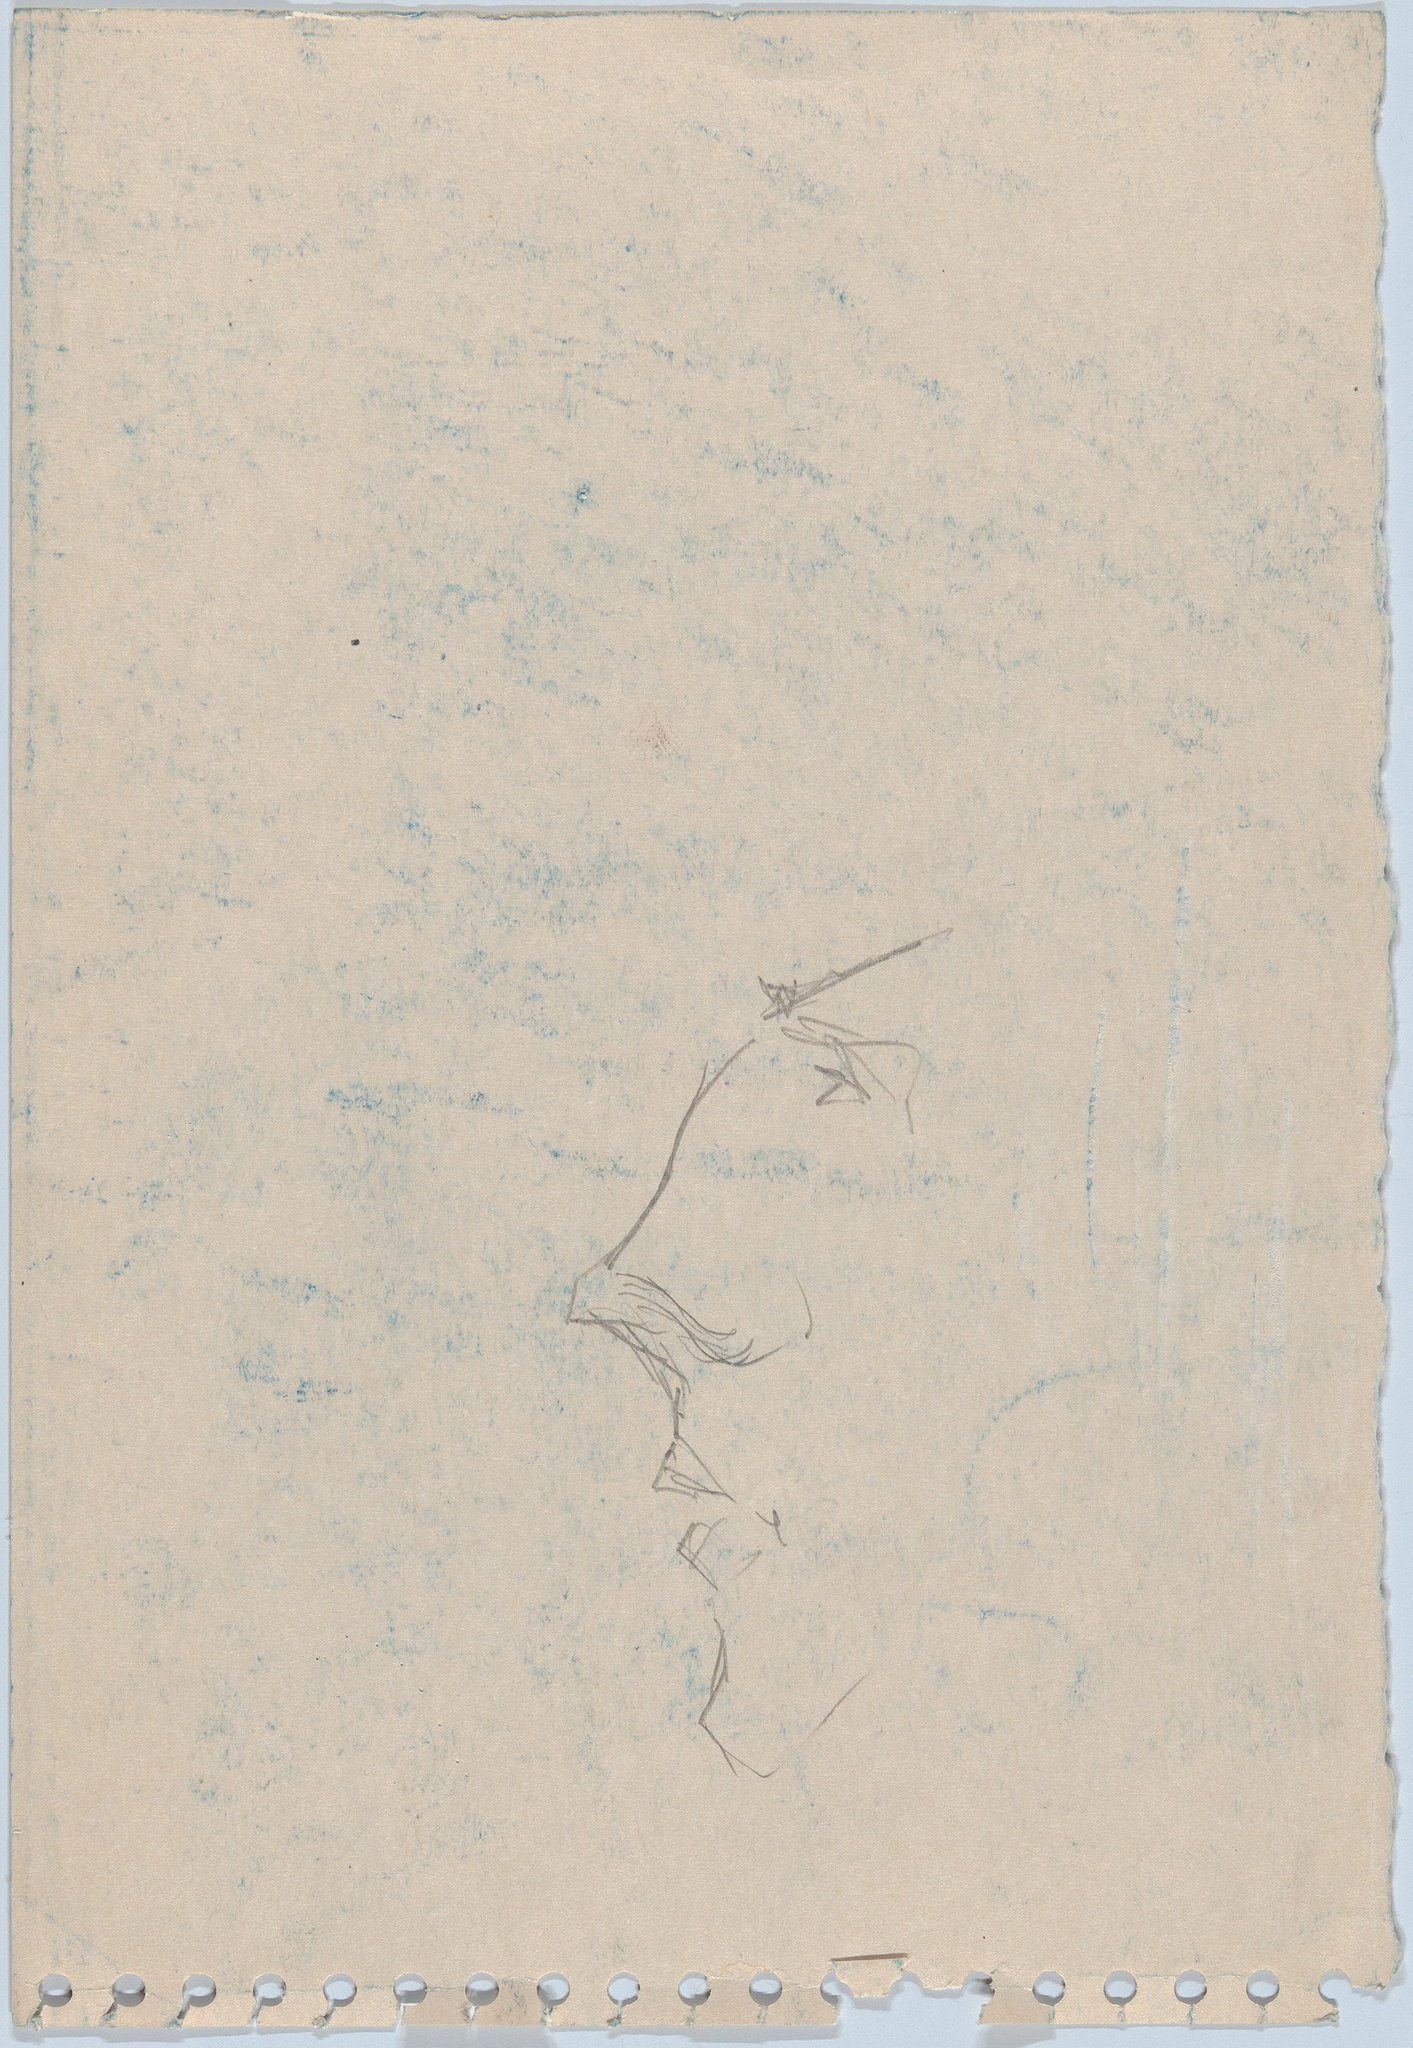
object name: drawing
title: Caricature of a man's head, seen in profile, in "Album of Woodcuts Collected by Arthur Heseltine"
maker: anonymous, british, 19th century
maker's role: artist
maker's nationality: british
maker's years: 1800-1900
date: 1873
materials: graphite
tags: men,profiles